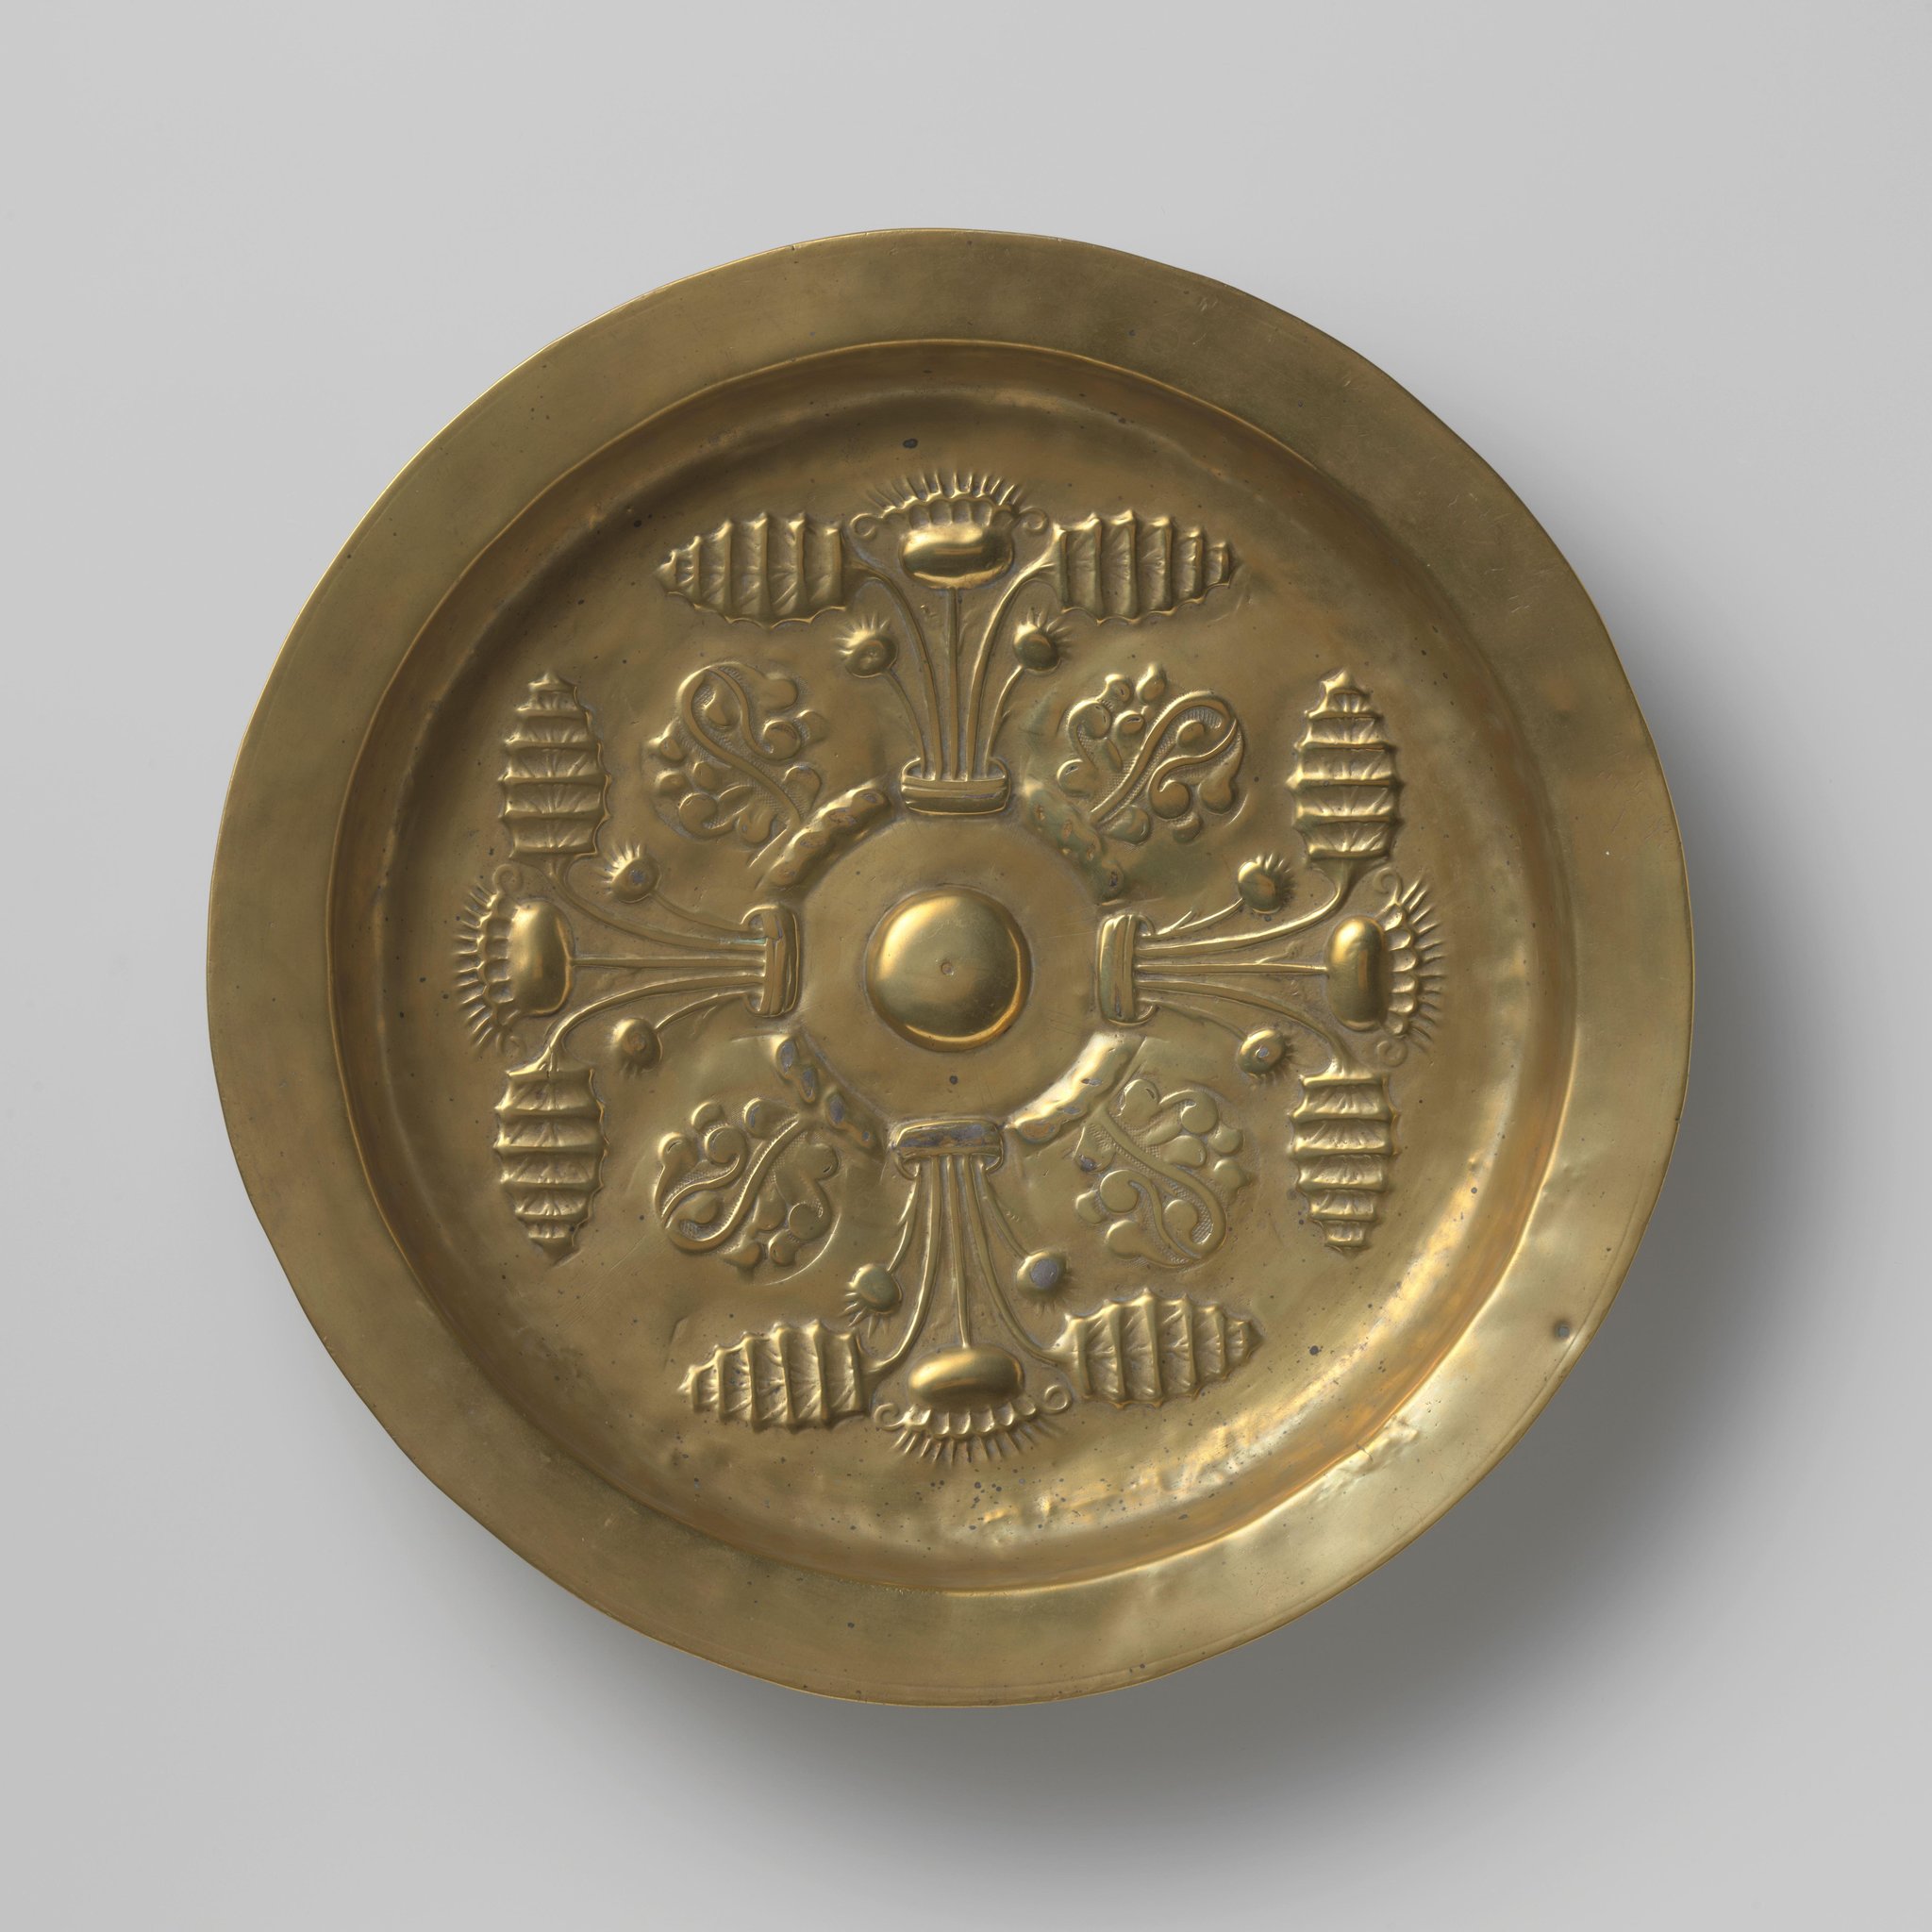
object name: platter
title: Schotel versierd met vier distelbloemen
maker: Anonymous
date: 1450-1500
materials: brass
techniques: casting, punching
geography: nuremberg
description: In het plat van de schotel, die in het midden het centerpunt heeft, zijn met behulp van stempelvormen geponst: een rond hoog middendeel, omgeven door een in een bak geplaatste plant bestaande uit een distelbloem, twee bladeren en twee bloemknoppen, en een gestileerde bladvorm op een randgedeelte. Deze motieven zijn vier maal herhaald. Langs de rand van de schotel is een daarmee parallel lopende ring gegroefd en een gaatje geboord. In latere tijd zijn aan de achterkant slijtageplekken met tin of lood hersteld en is een hangring gesoldeerd.